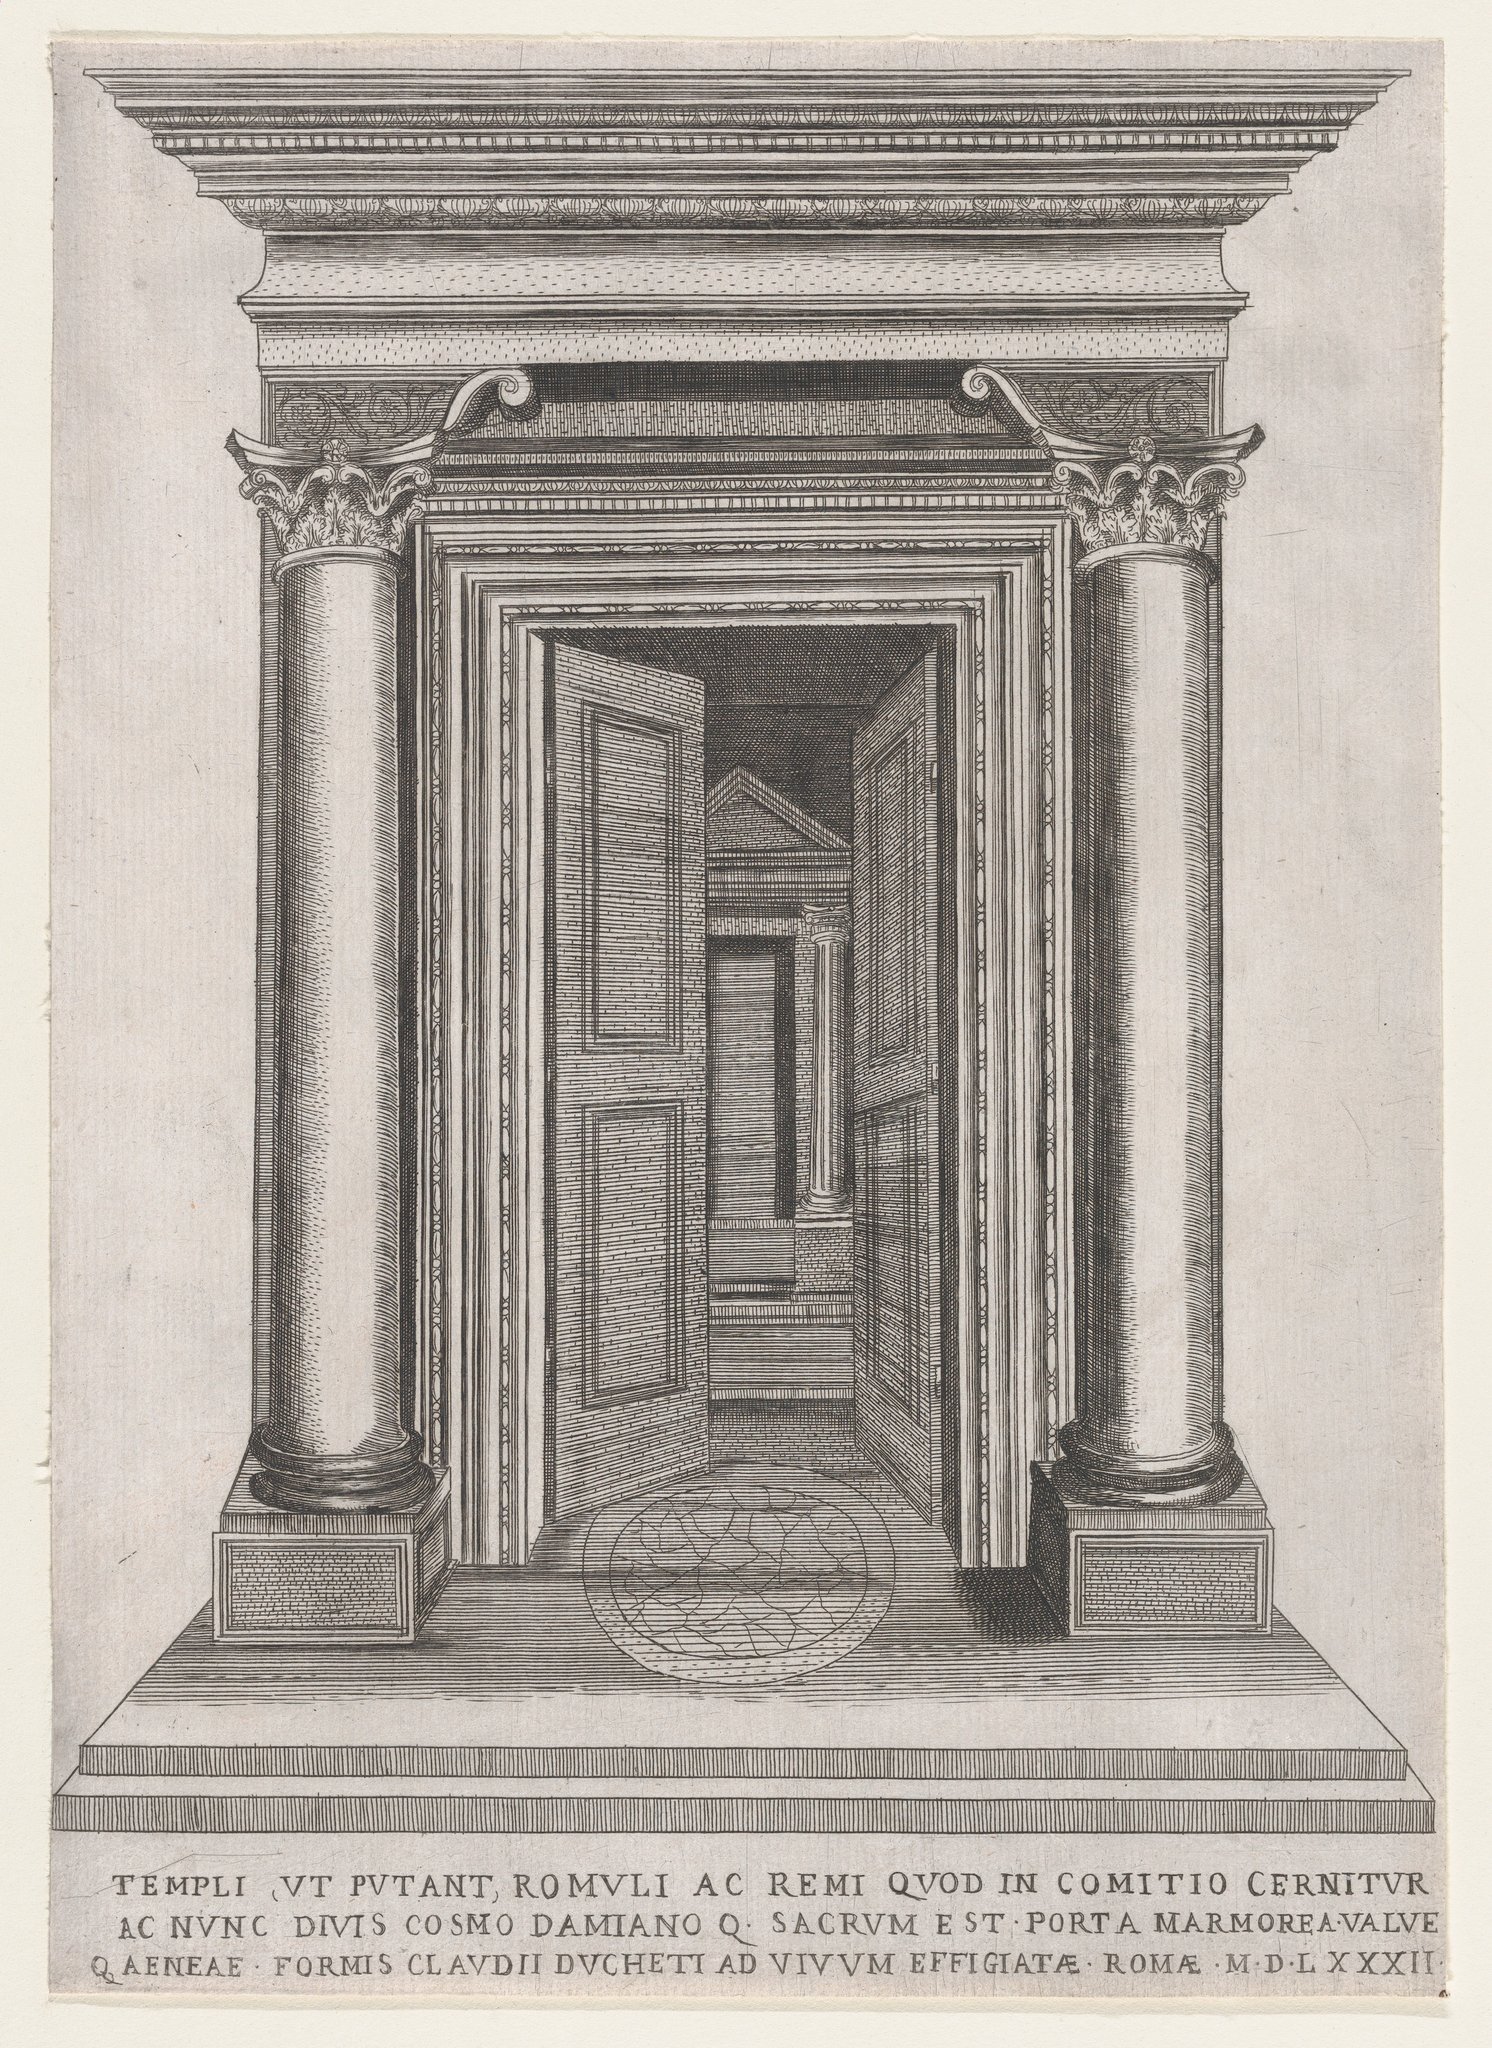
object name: print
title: Portal of the Temple of Romulus and Remus, from "Speculum Romanae Magnificentiae"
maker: Anonymous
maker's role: artist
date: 1582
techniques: engraving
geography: rome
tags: architecture,rome